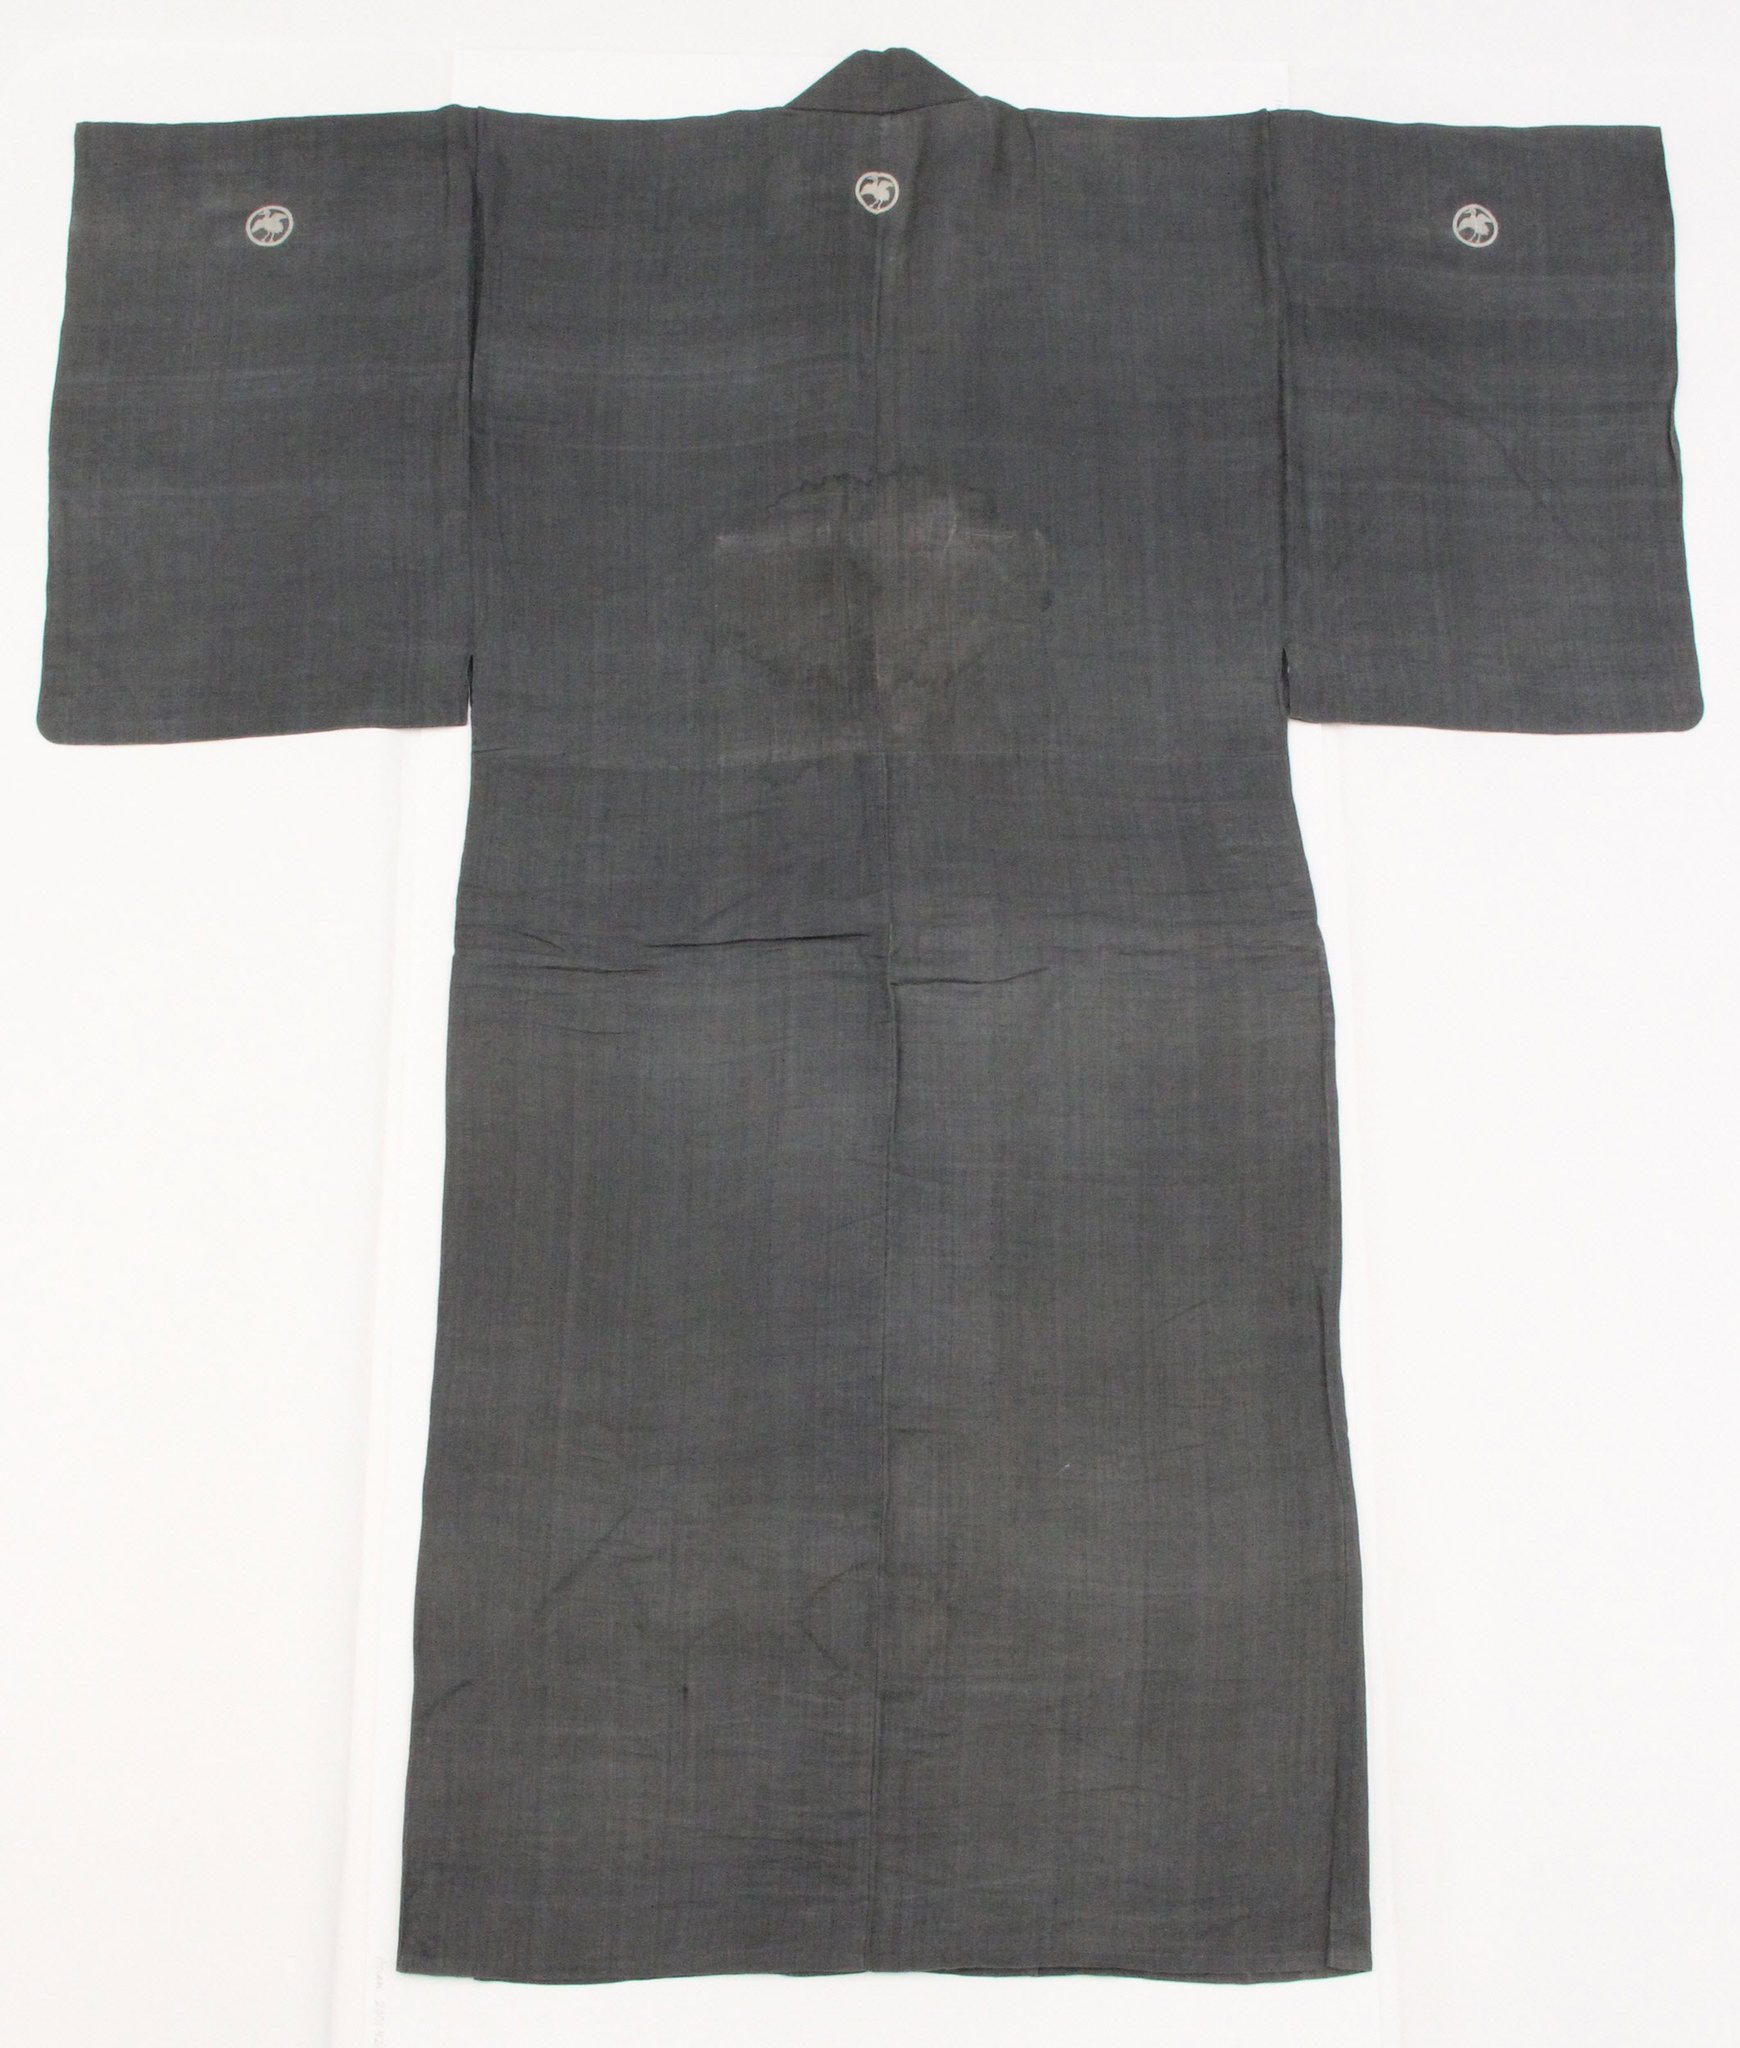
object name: kosode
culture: japanese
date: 1615-1868